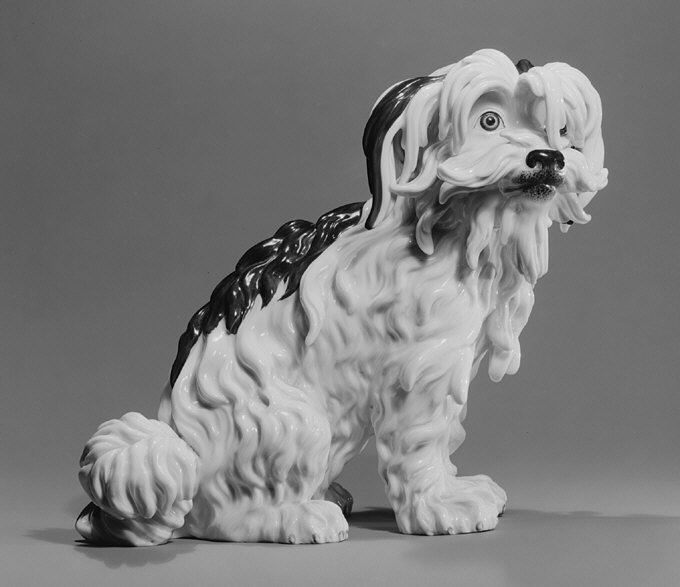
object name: figure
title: Bolognese Terrier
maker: popov manufactory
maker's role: manufactory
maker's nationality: russian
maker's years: 1811-1875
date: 1811-1850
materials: hard paste porcelain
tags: dogs